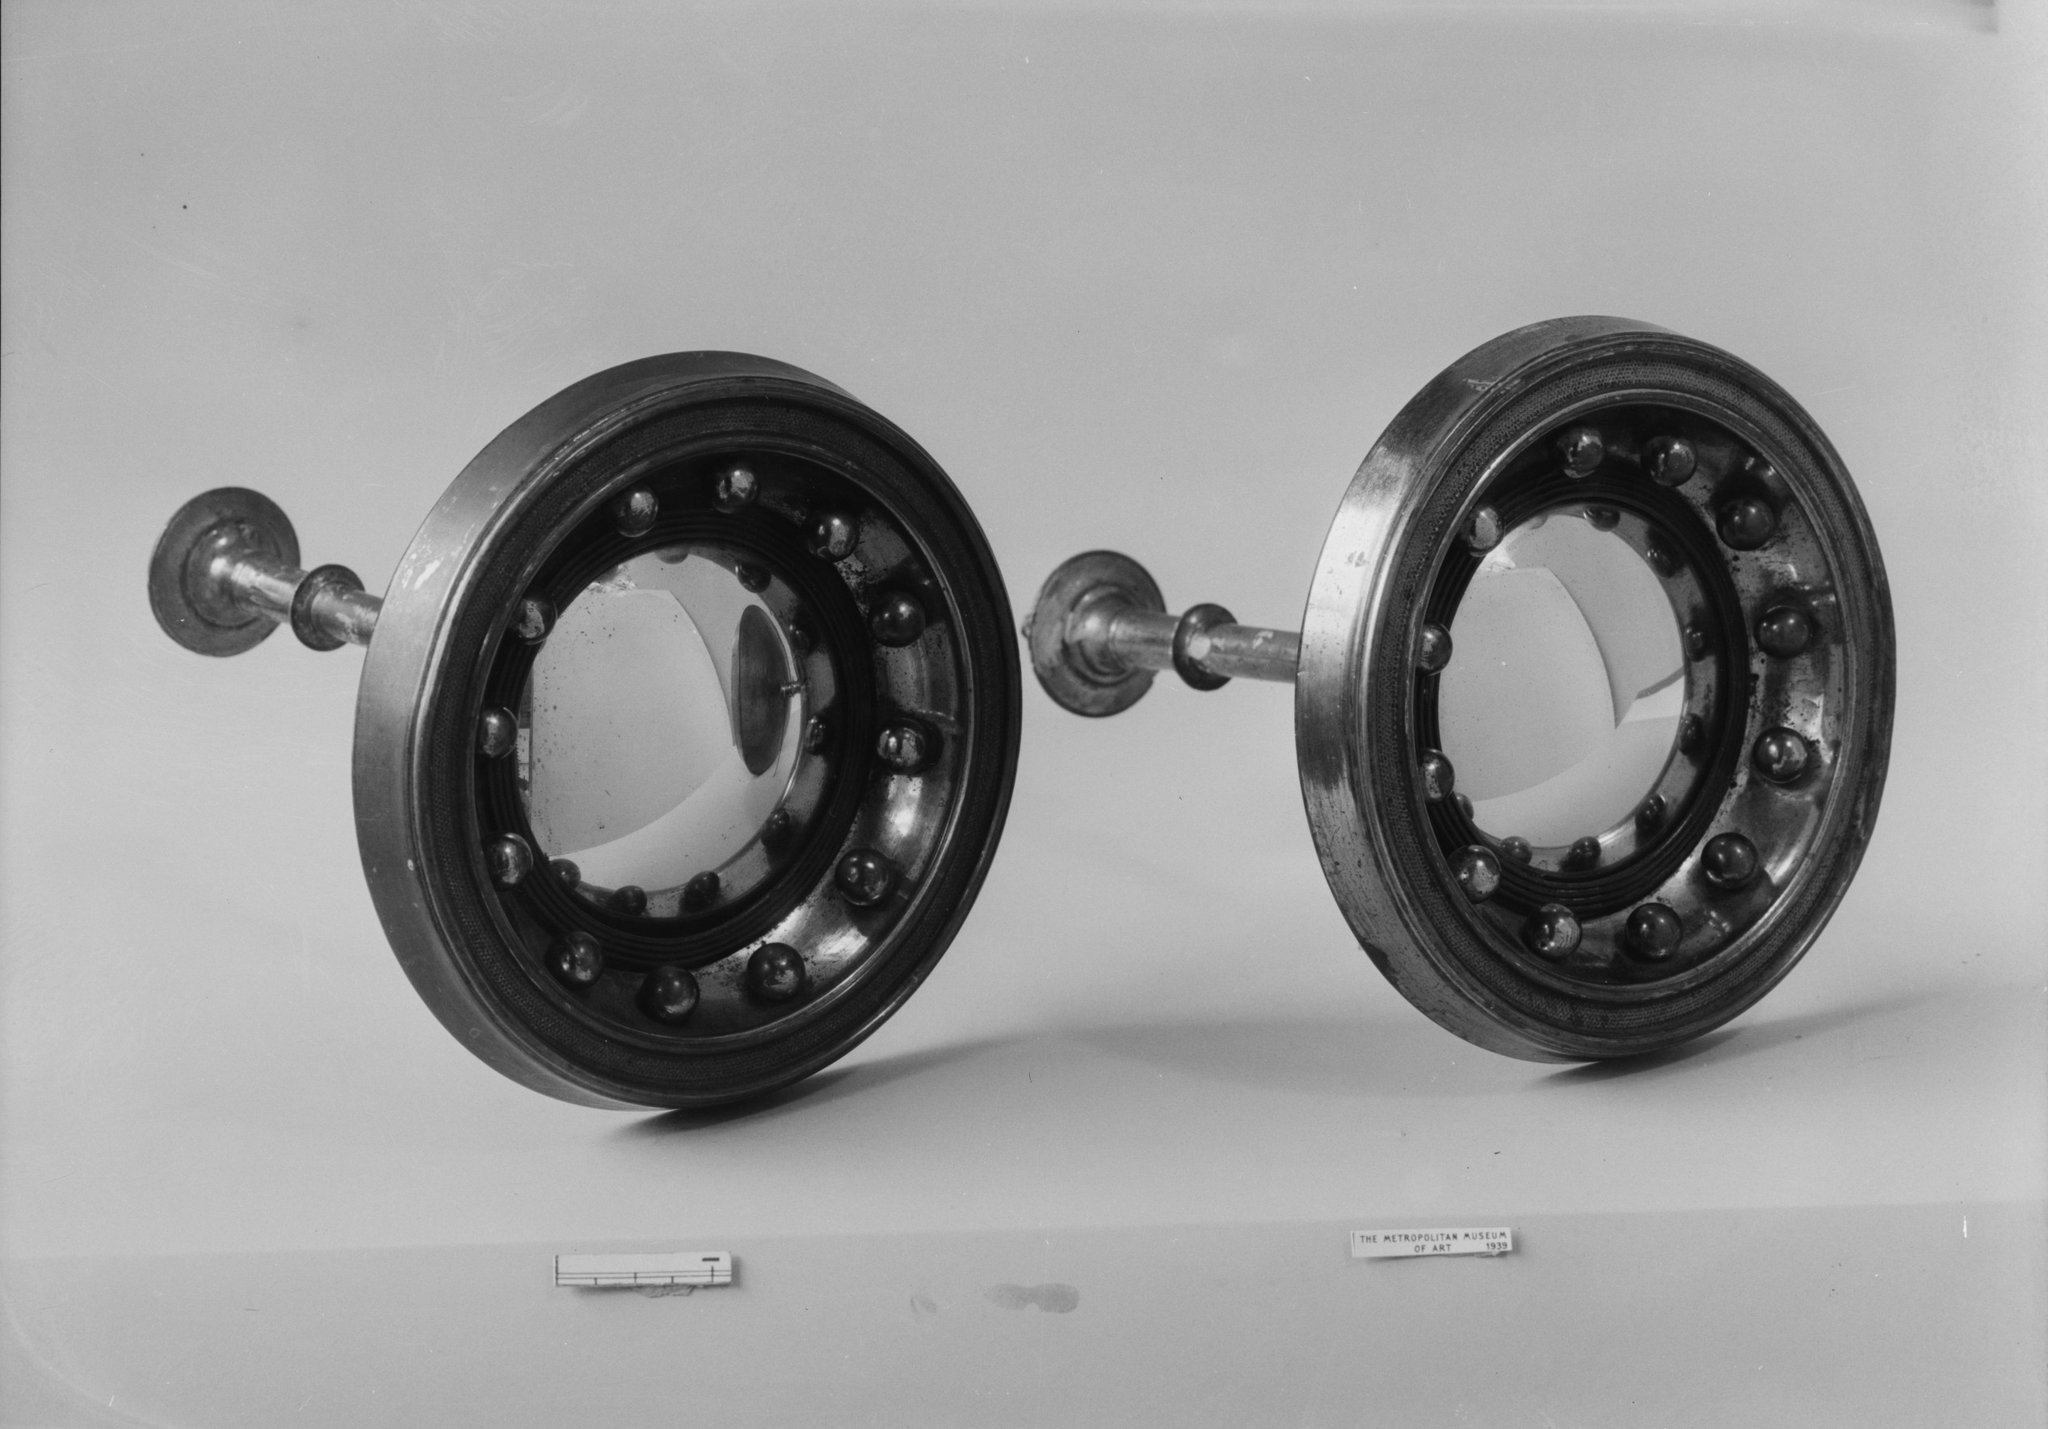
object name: curtain knob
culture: american or british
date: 1800-1900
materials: brass, glass, wood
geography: england